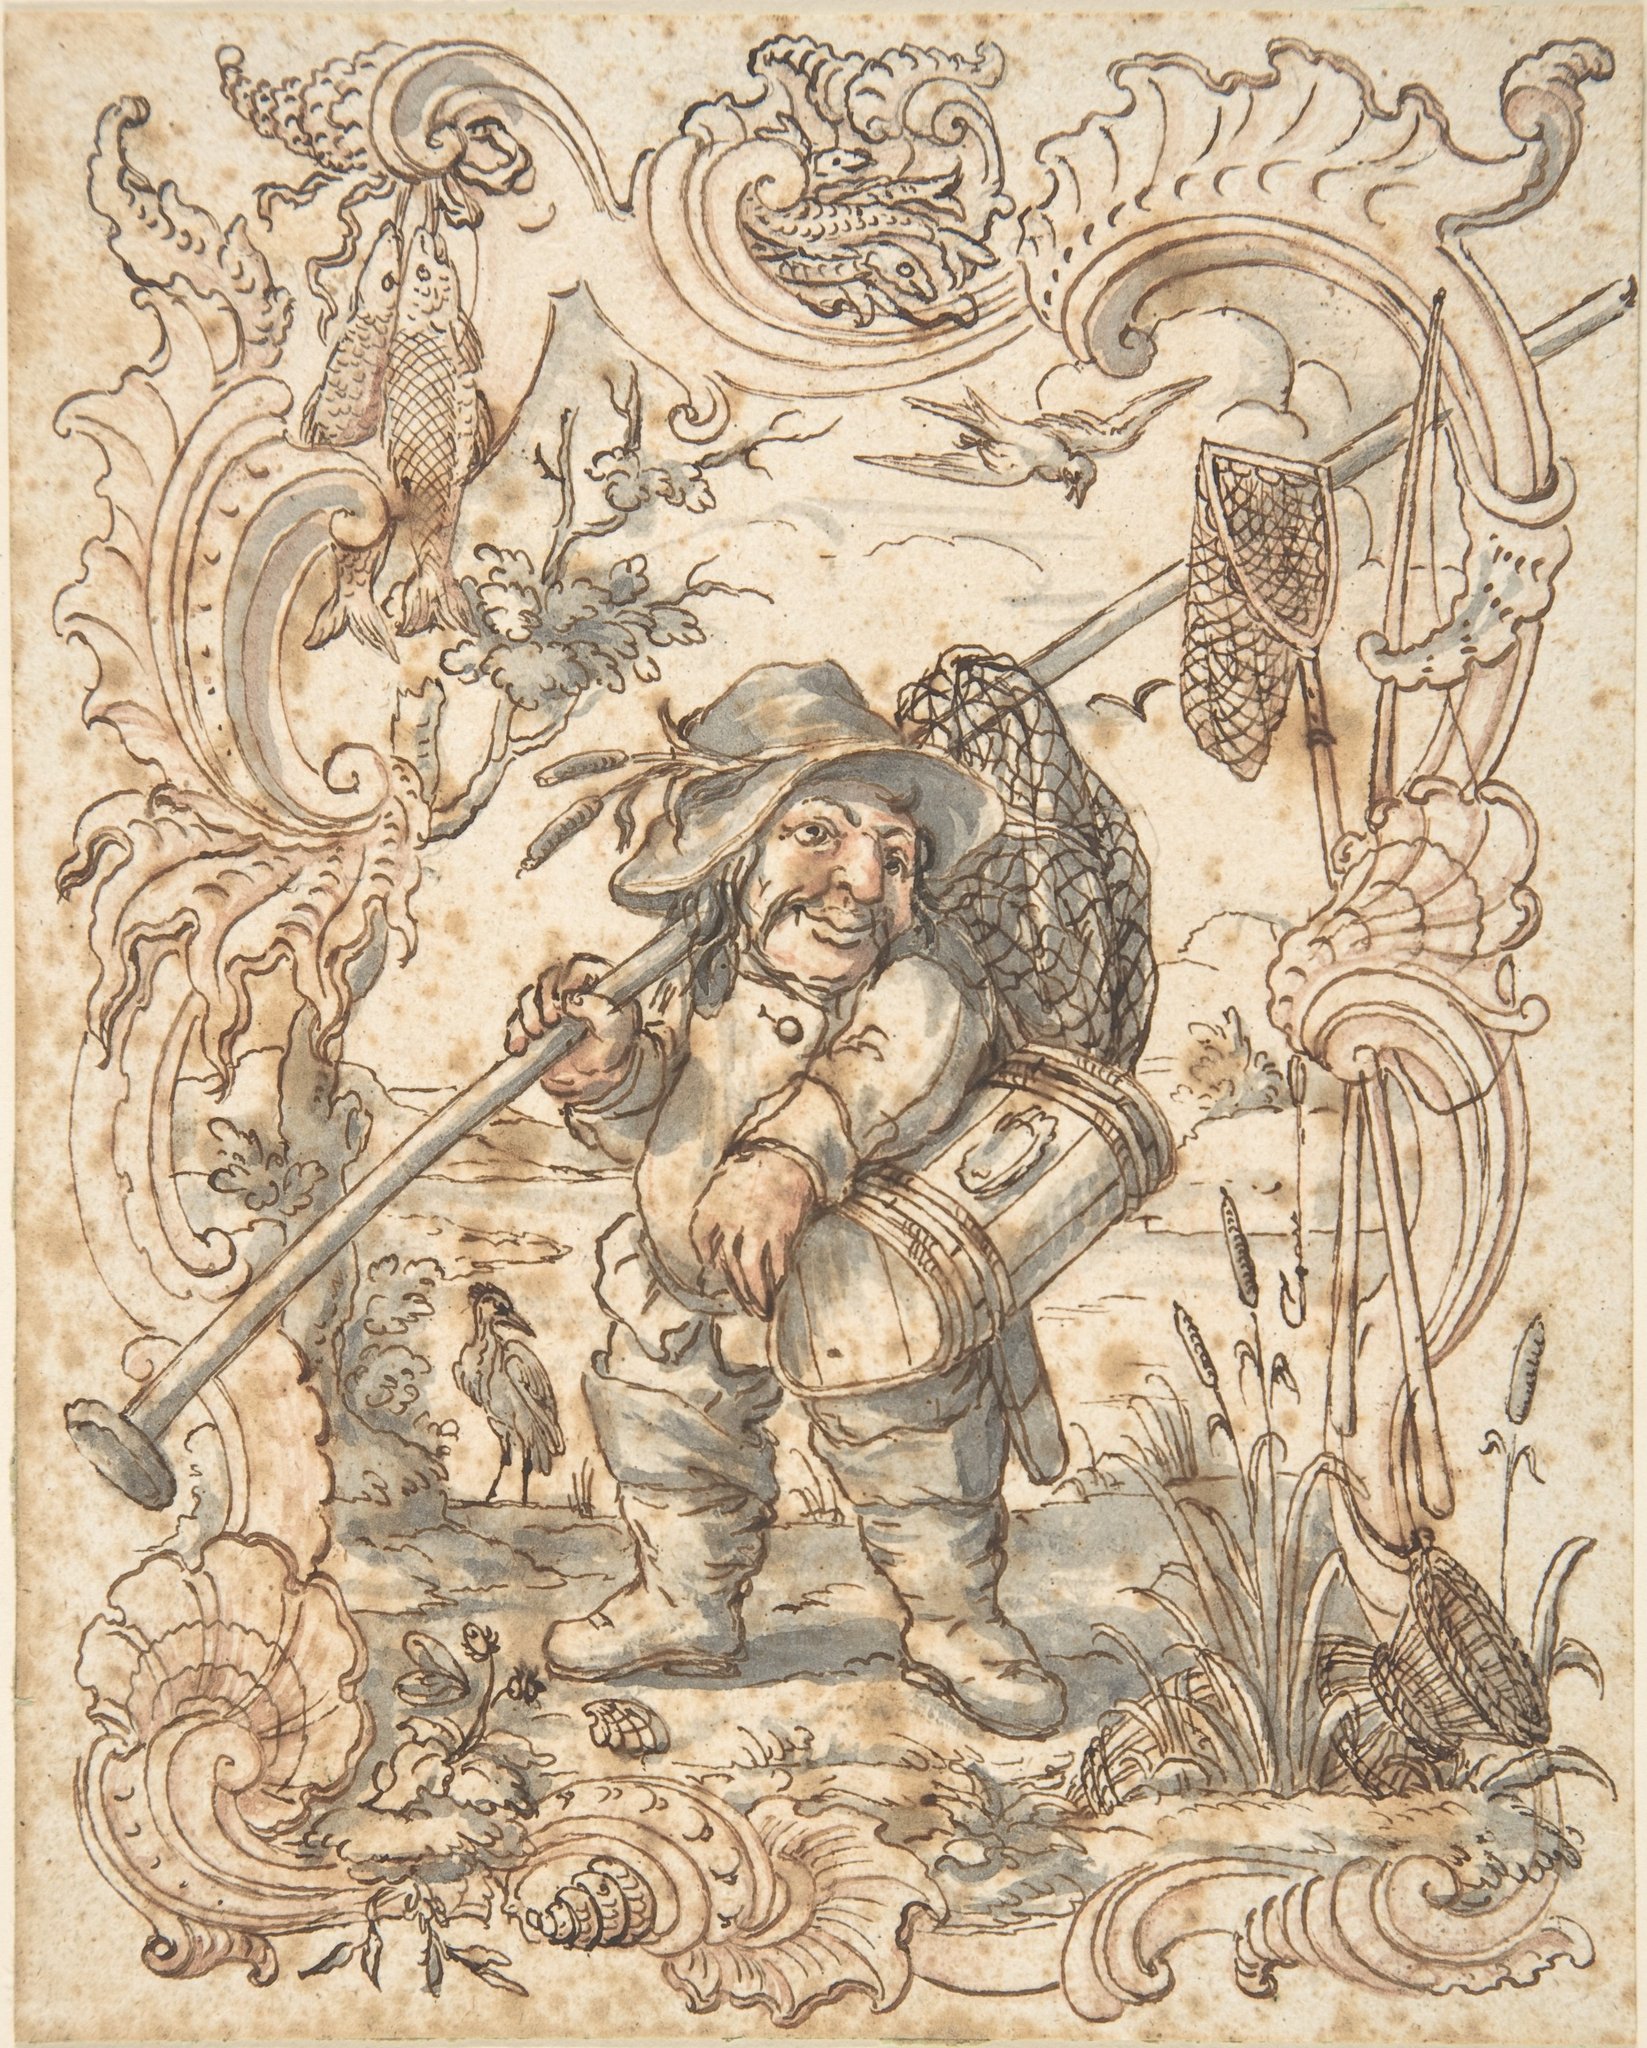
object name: drawing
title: Caricatures of a Fish and a Bird Peddler in Ornamental Frames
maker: johann esaias nilson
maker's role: artist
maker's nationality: german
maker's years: 1721-1788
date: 1735-1788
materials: ink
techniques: pen, wash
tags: men,fish